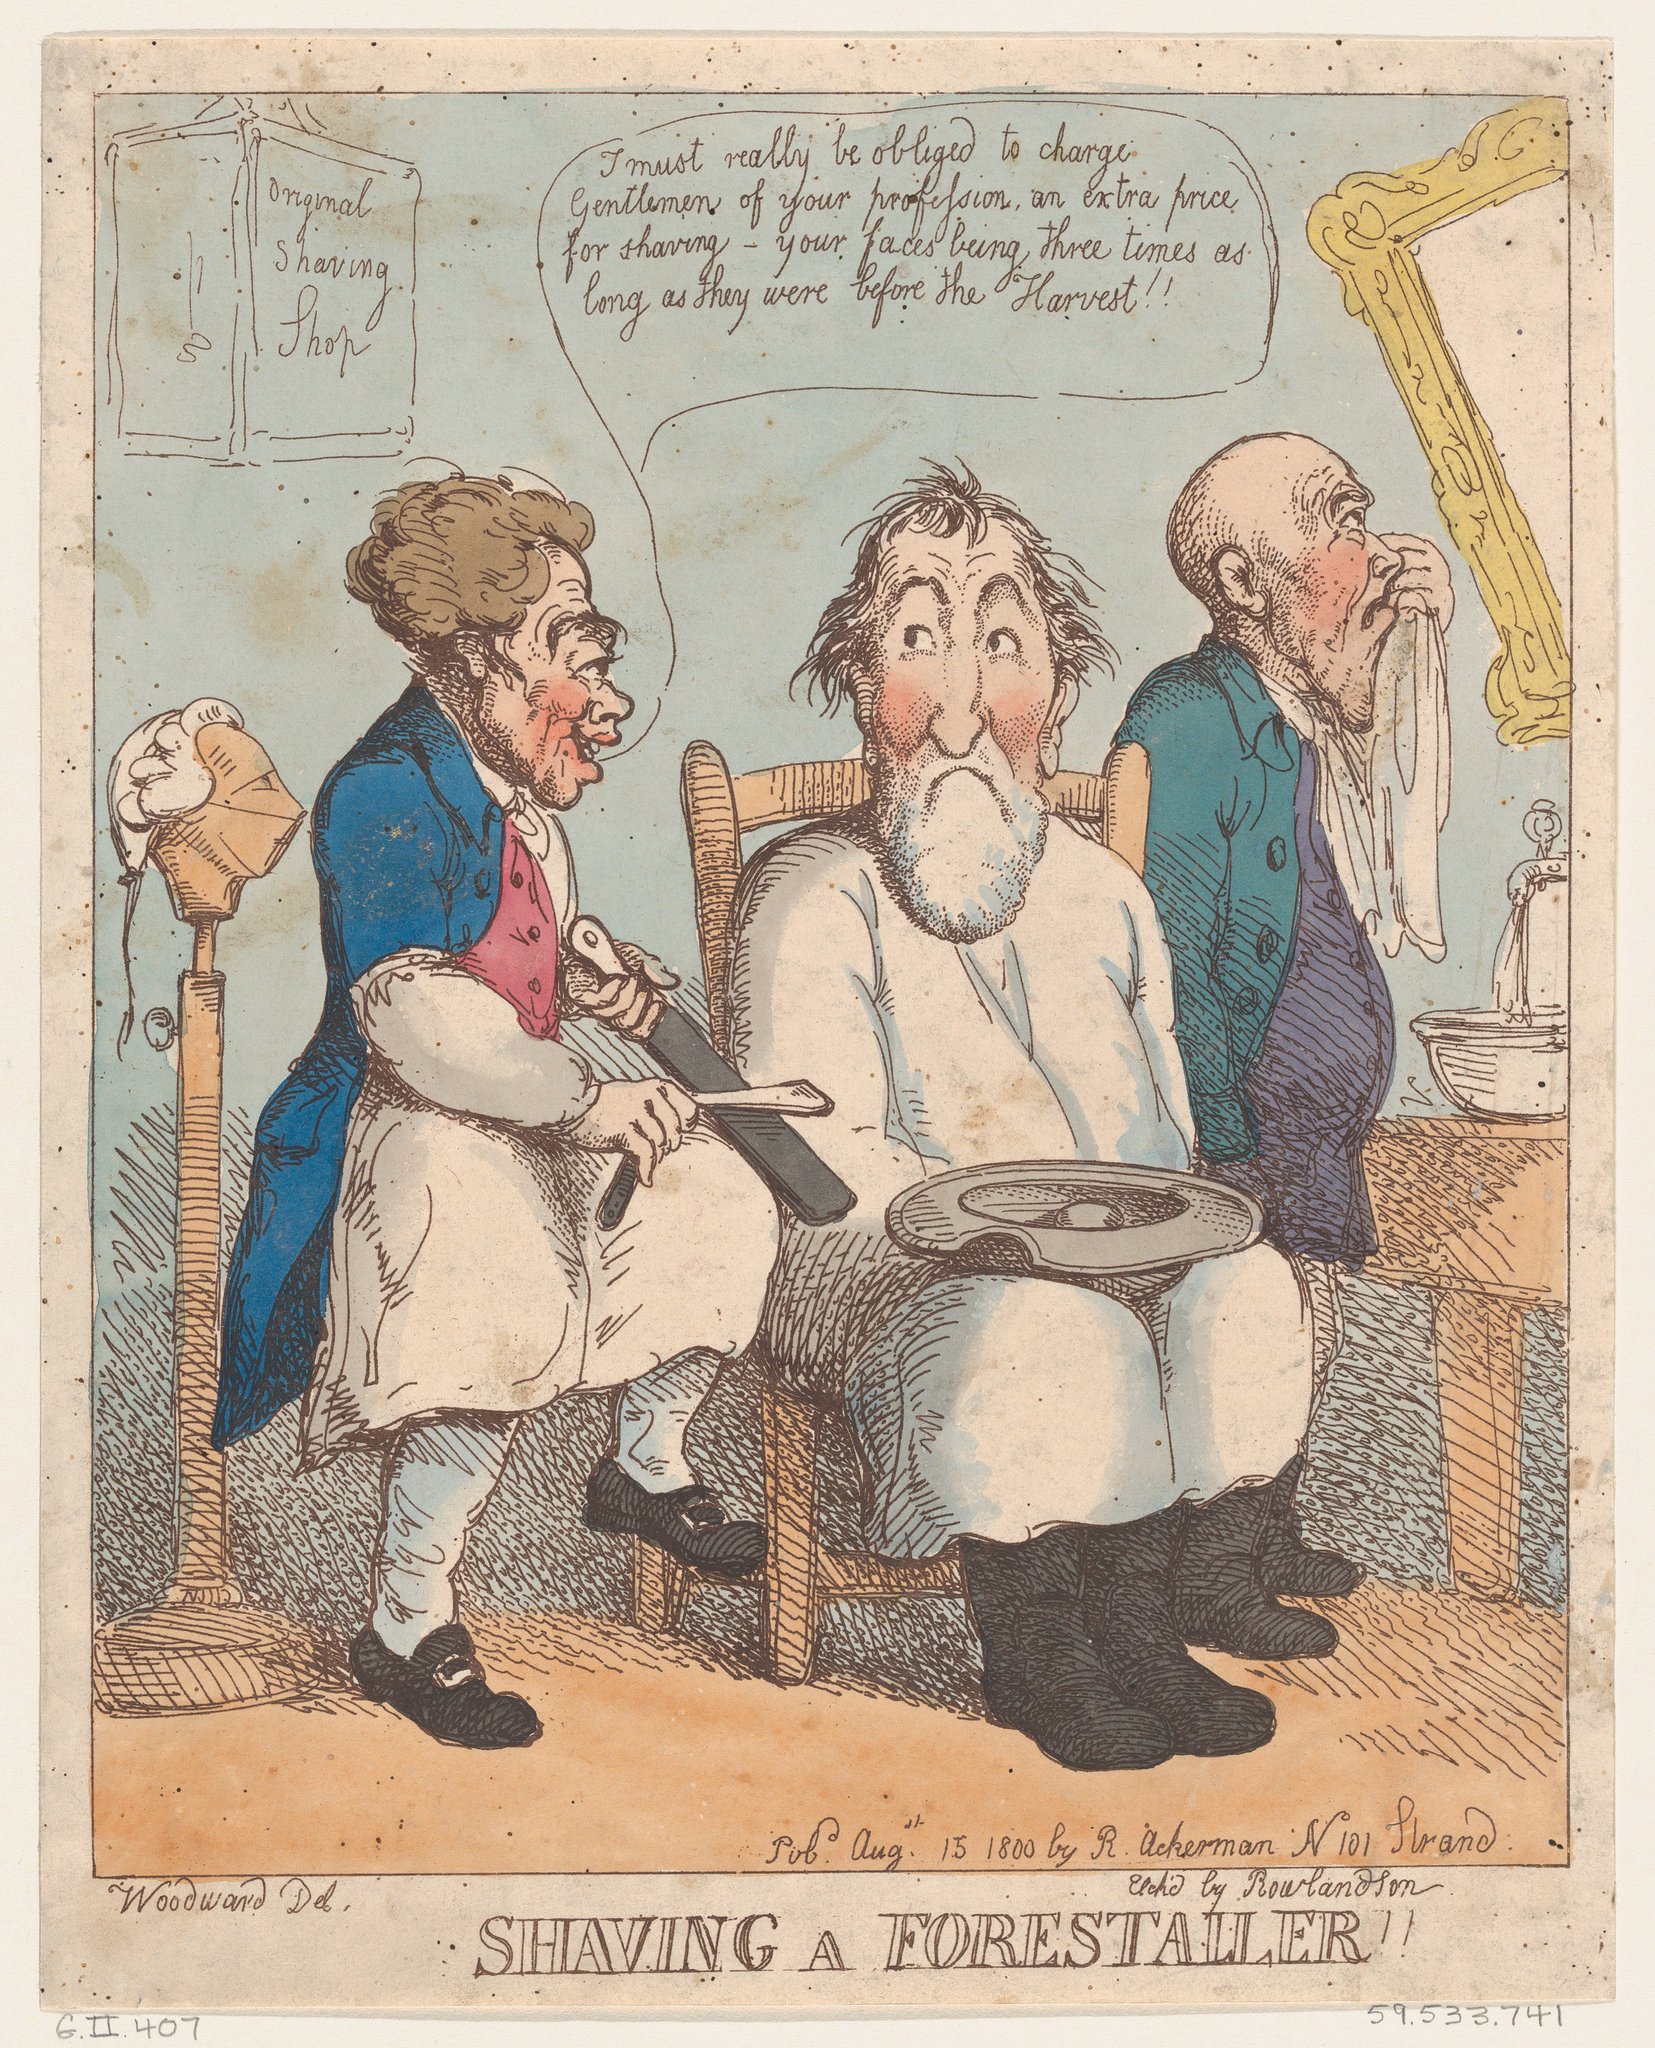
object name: print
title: Shaving a Forestaller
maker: thomas rowlandson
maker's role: artist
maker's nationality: british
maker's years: 1757-1827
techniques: etching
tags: men